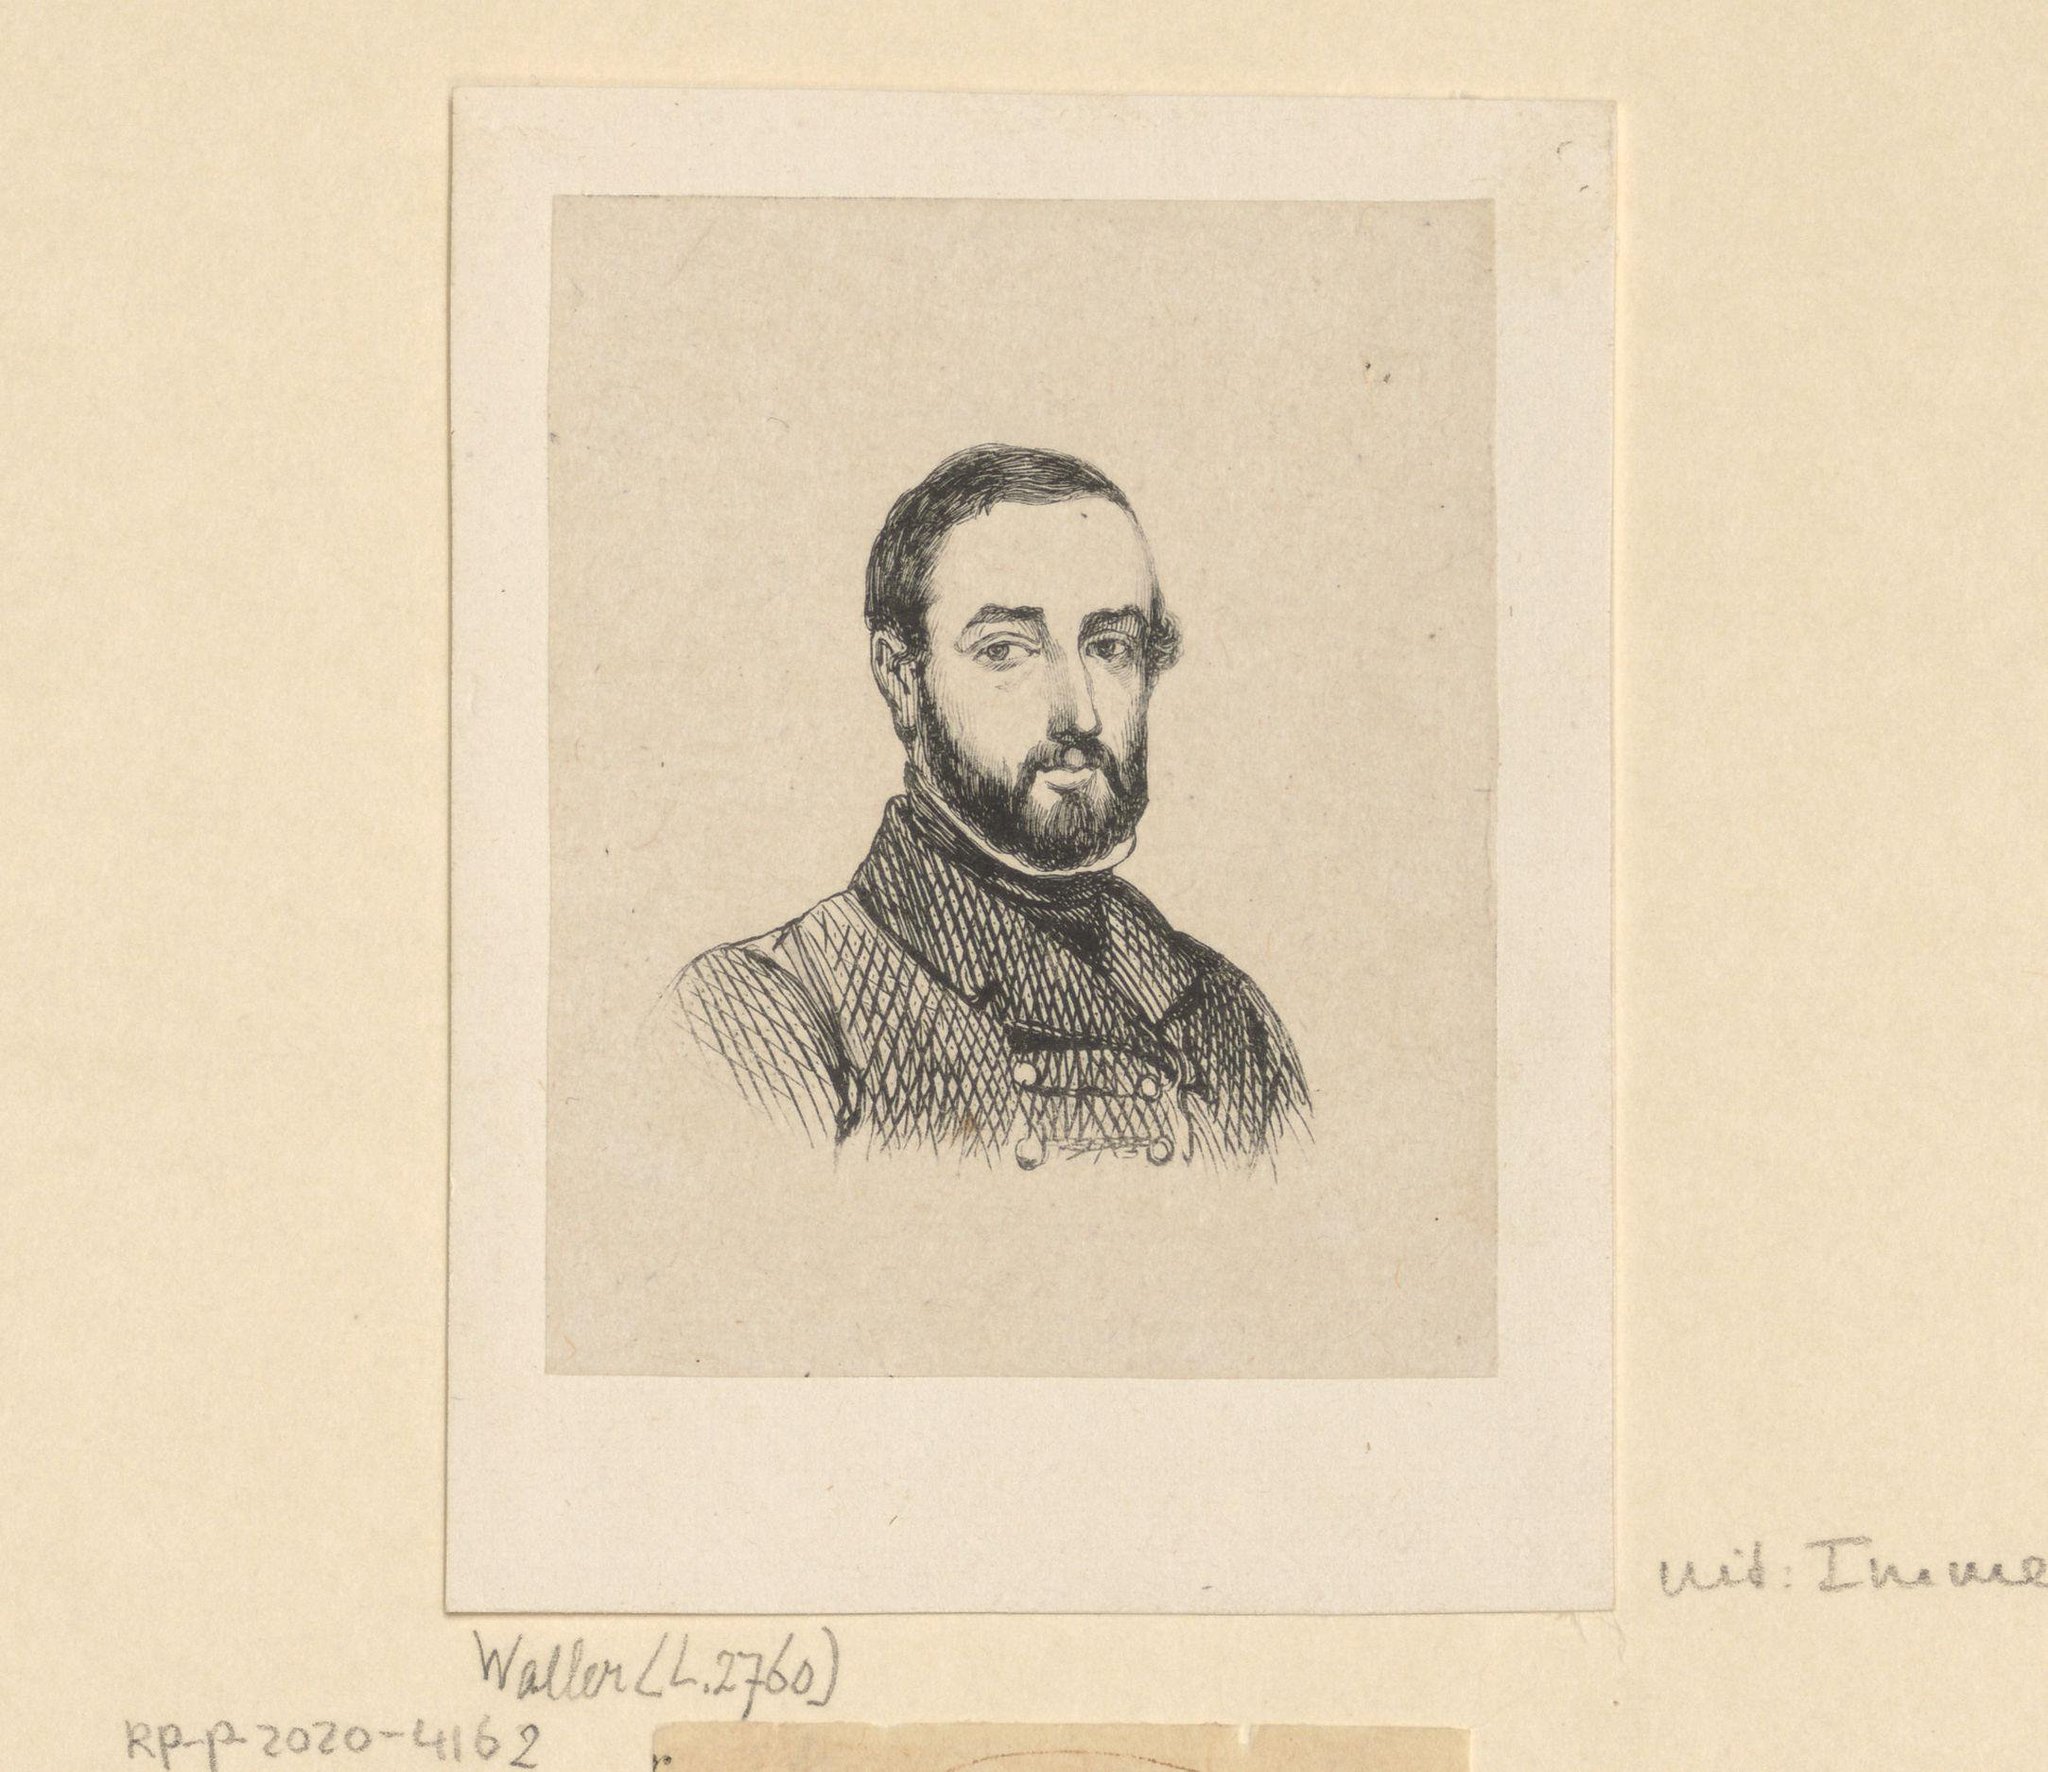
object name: print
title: Portret van Louis Gallait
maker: Anonymous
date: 1820-1887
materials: paper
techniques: engraving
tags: painter, print maker, draughtsman, louis gallait, historical persons, portrait, self-portrait of painter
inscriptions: collector's mark: Lugt 2166, collector's mark: Lugt 2760